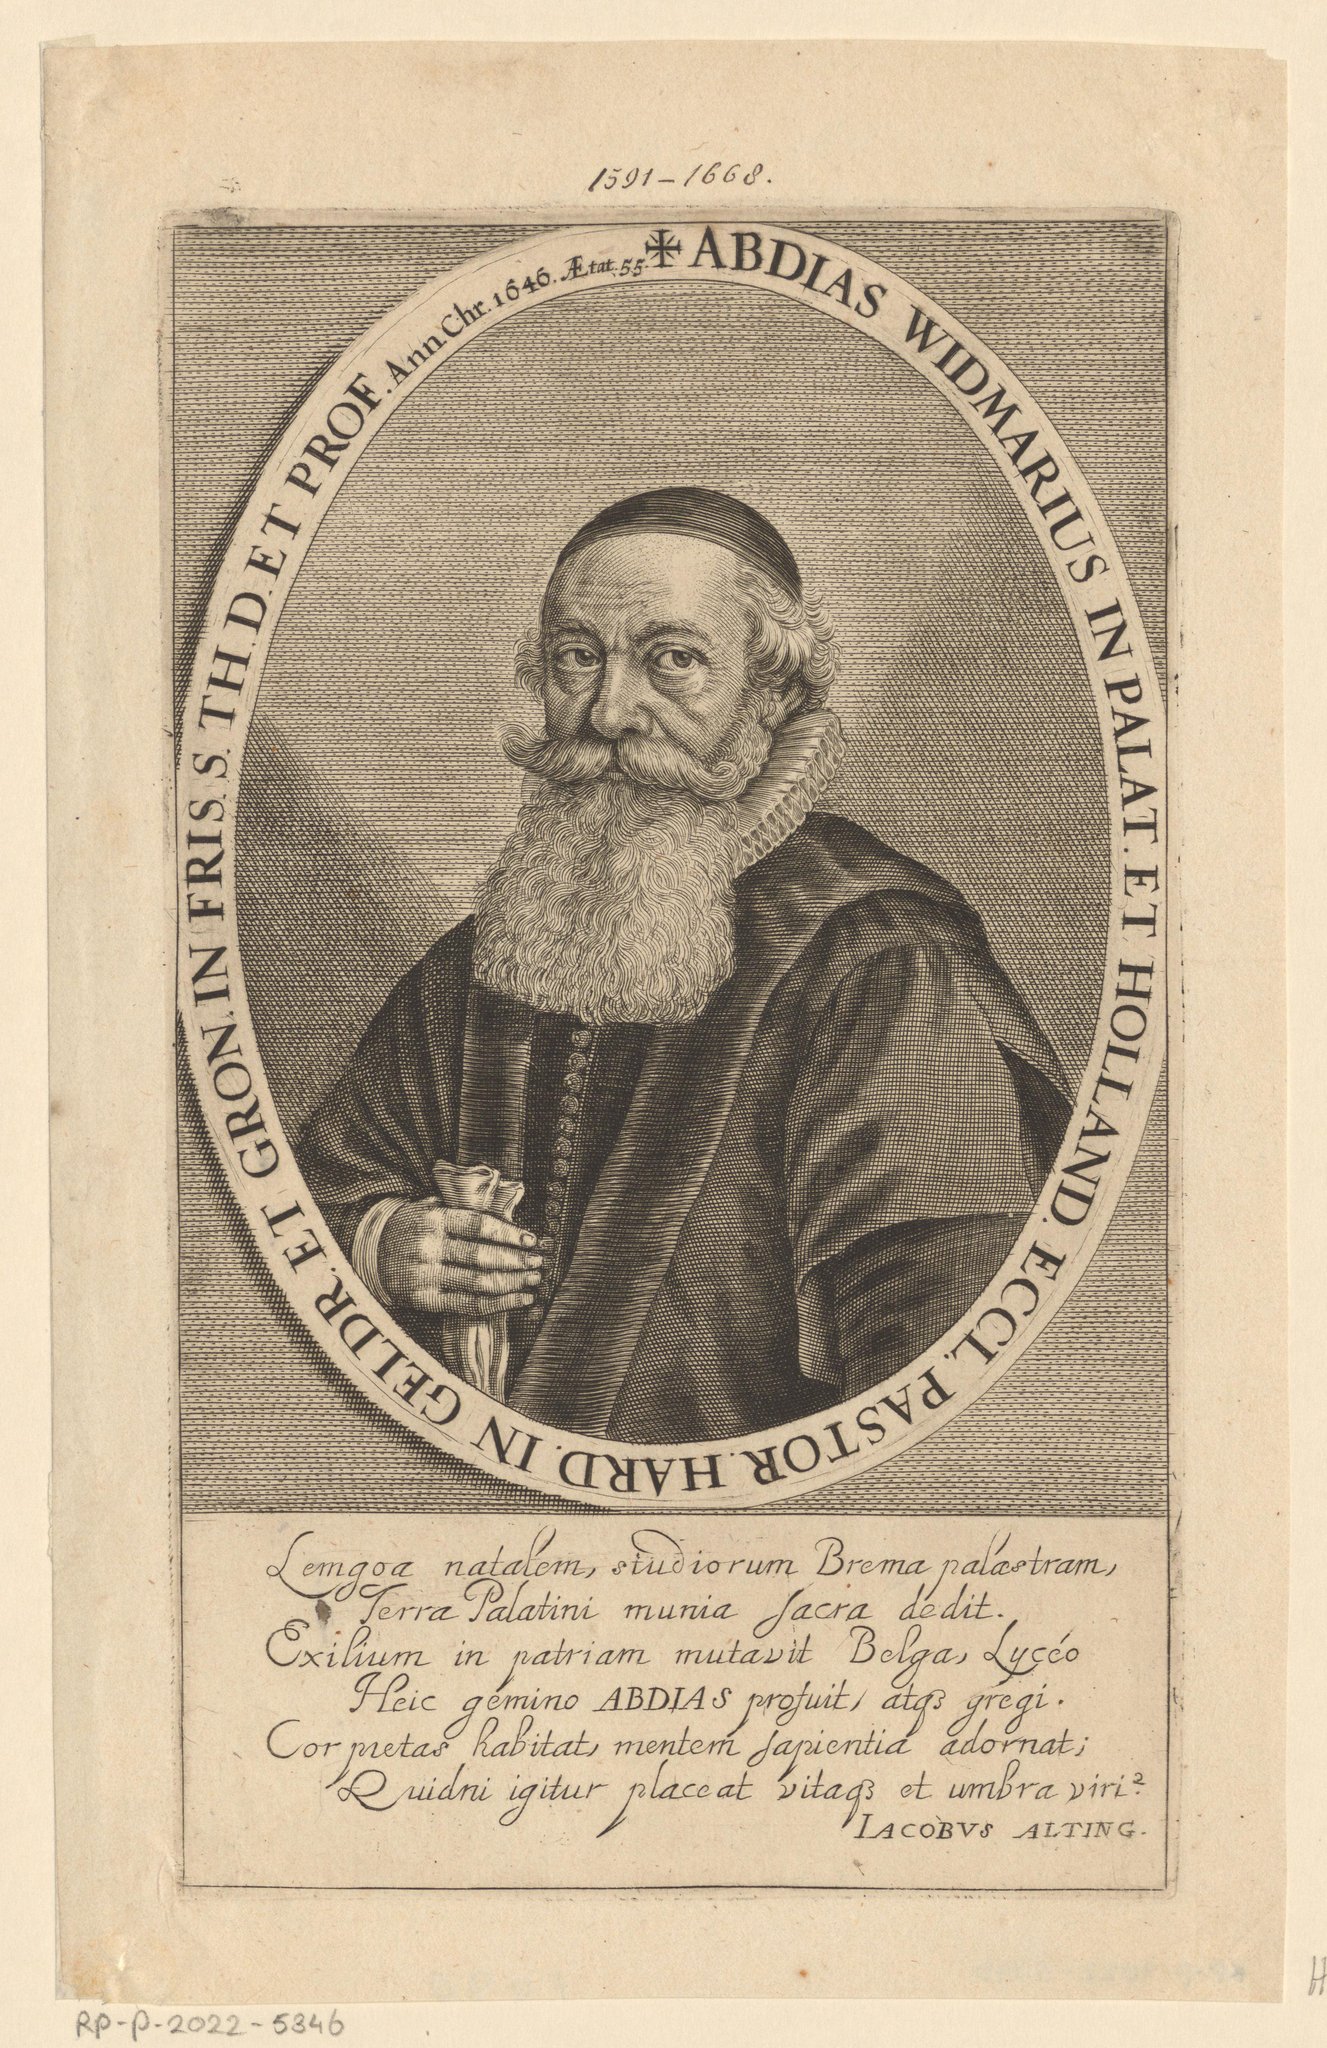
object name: print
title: Portret van Abdias Widmarius op 55-jarige leeftijd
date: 1654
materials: paper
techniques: engraving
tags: theologian, historical persons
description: Prent waarschijnlijk uit: Effigies & vitae Professorvm Academiae Groningae & Omlandiae. Groningen: Johannes Nicolai, 1654.